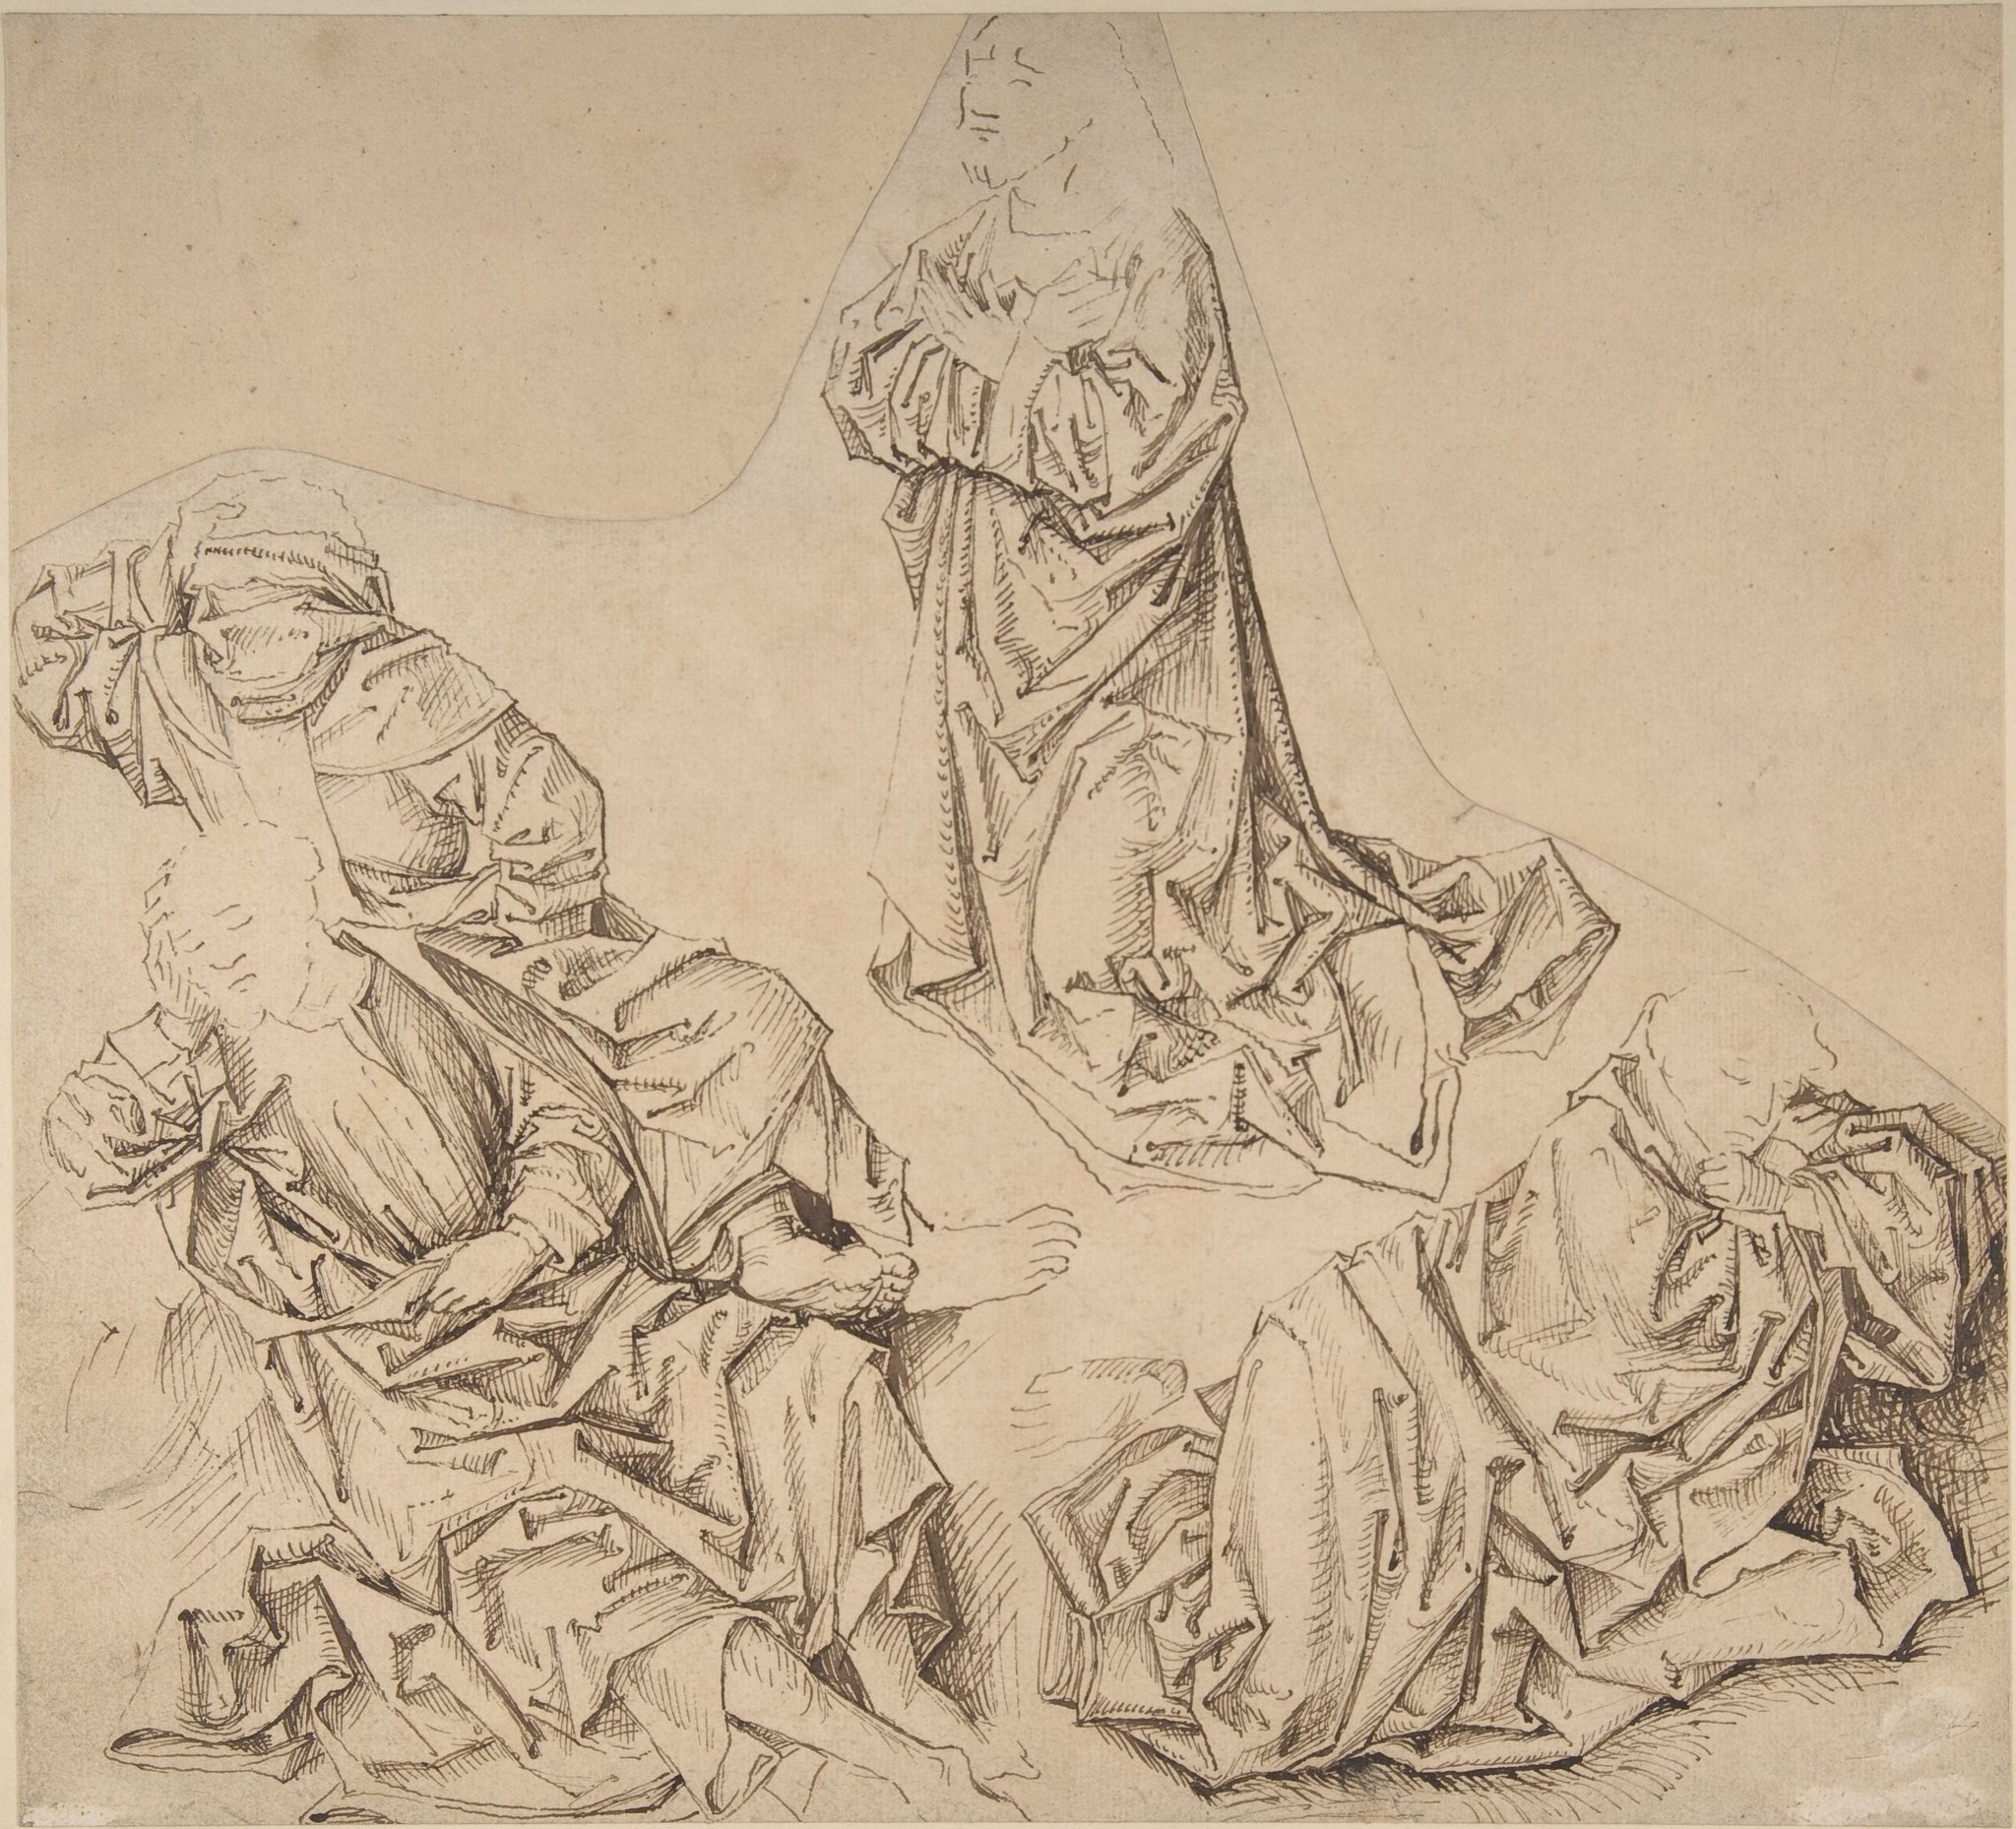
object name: drawing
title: Christ in Gethsemane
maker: anonymous, german, 16th century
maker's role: artist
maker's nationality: german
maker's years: 1500-1600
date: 1490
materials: ink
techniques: pen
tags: human figures,sleeping,christ